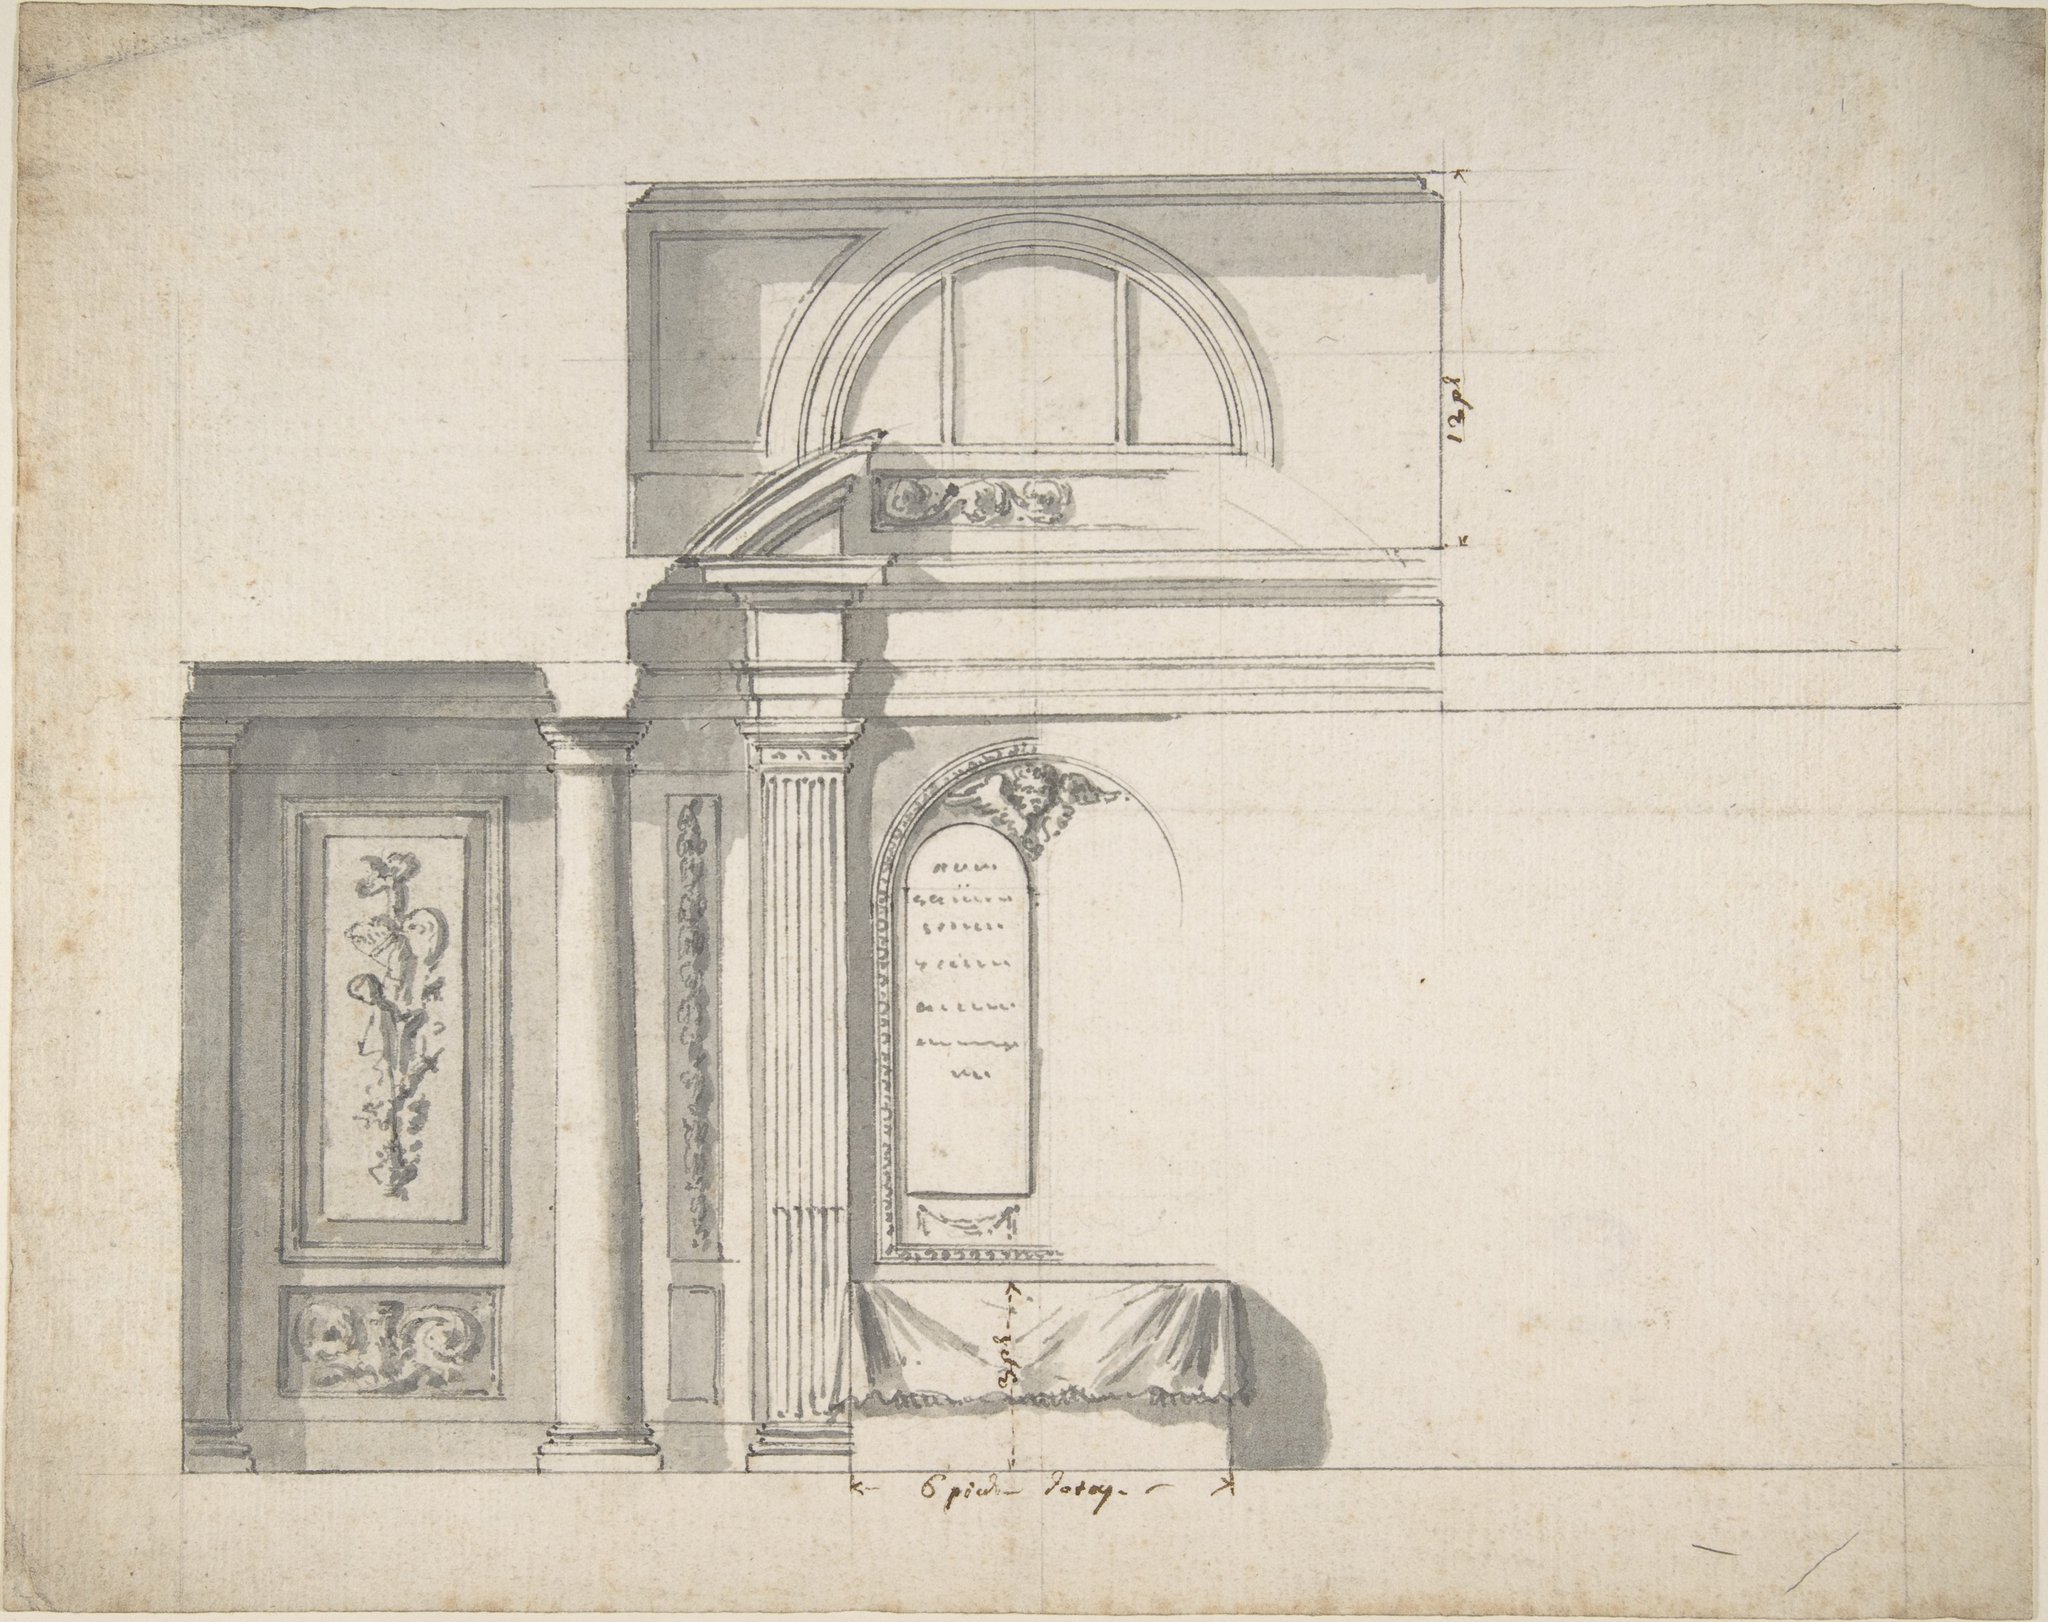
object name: drawing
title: Design for a monument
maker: anonymous, french, 18th century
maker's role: artist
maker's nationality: french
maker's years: 1700-1800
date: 1701-1800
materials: ink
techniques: pen, wash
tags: architecture